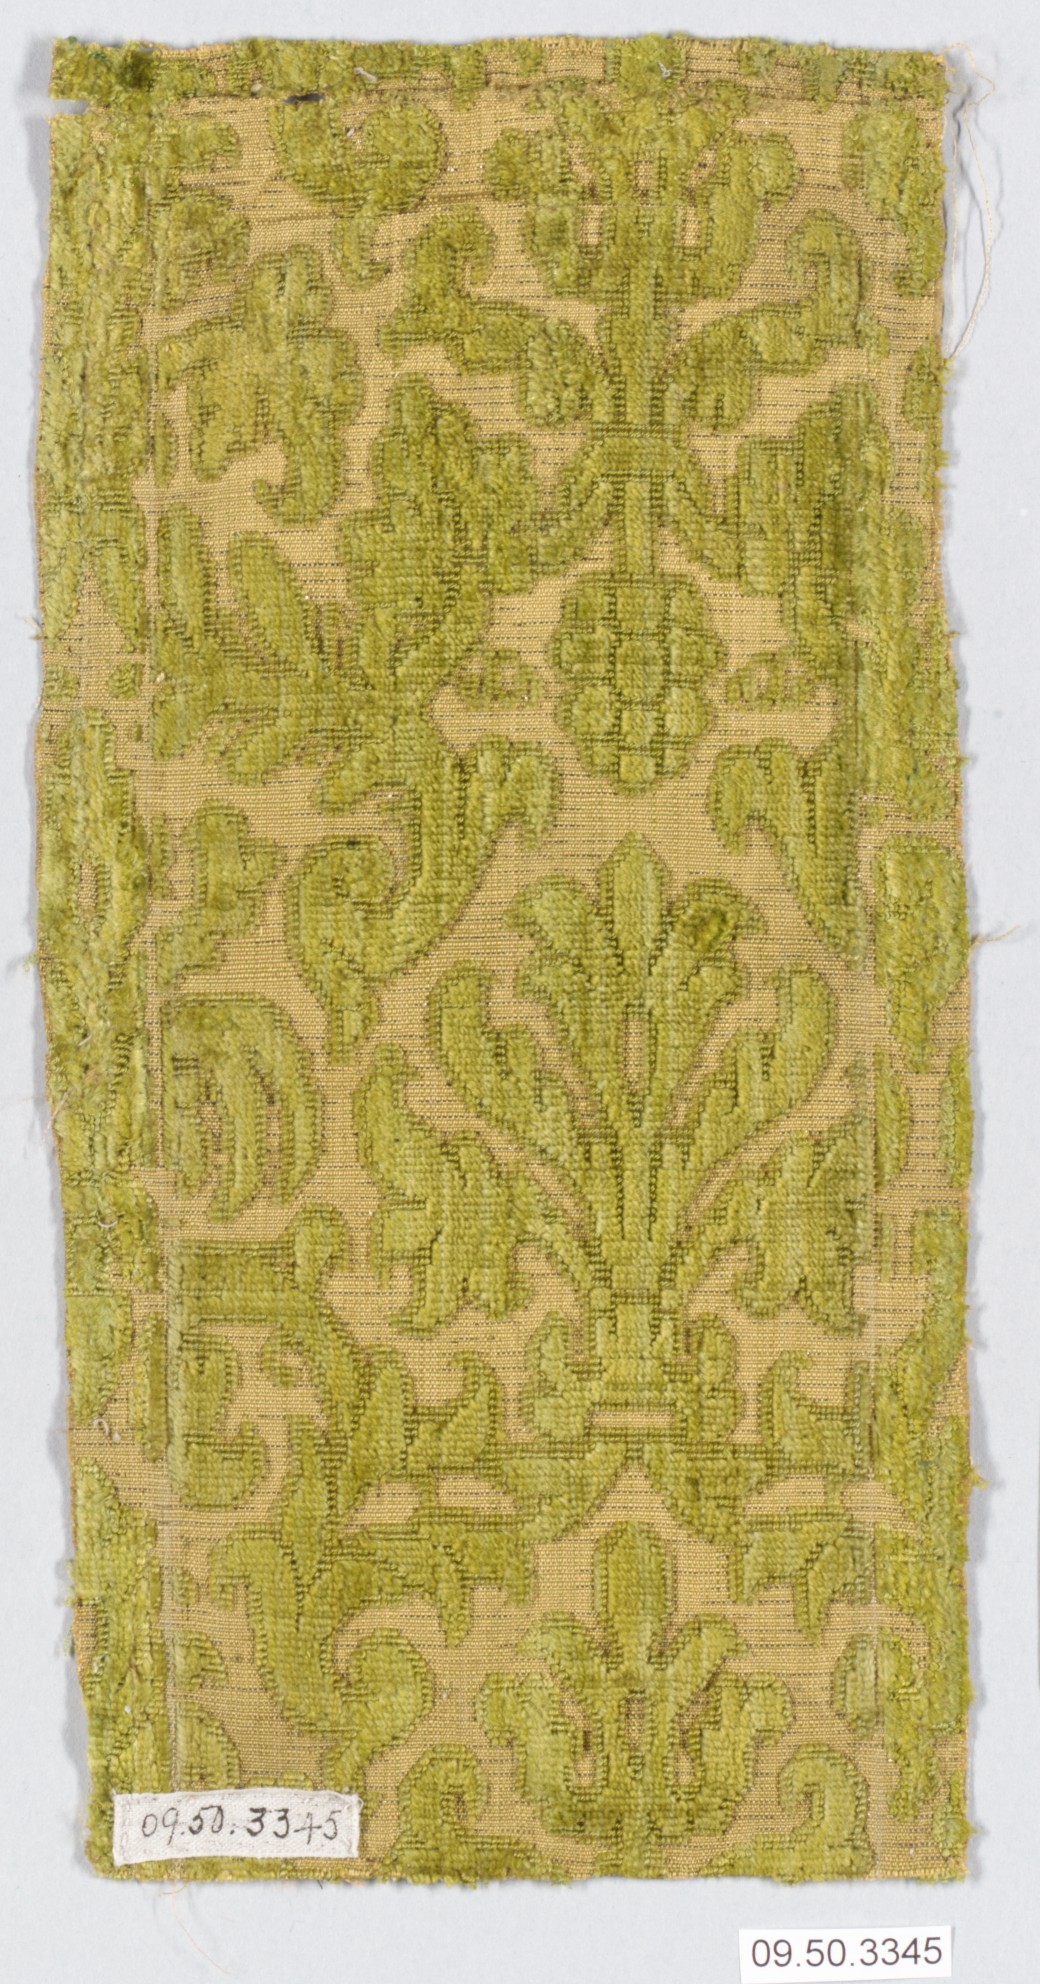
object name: piece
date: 1601-1700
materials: metal thread, silk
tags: leaves